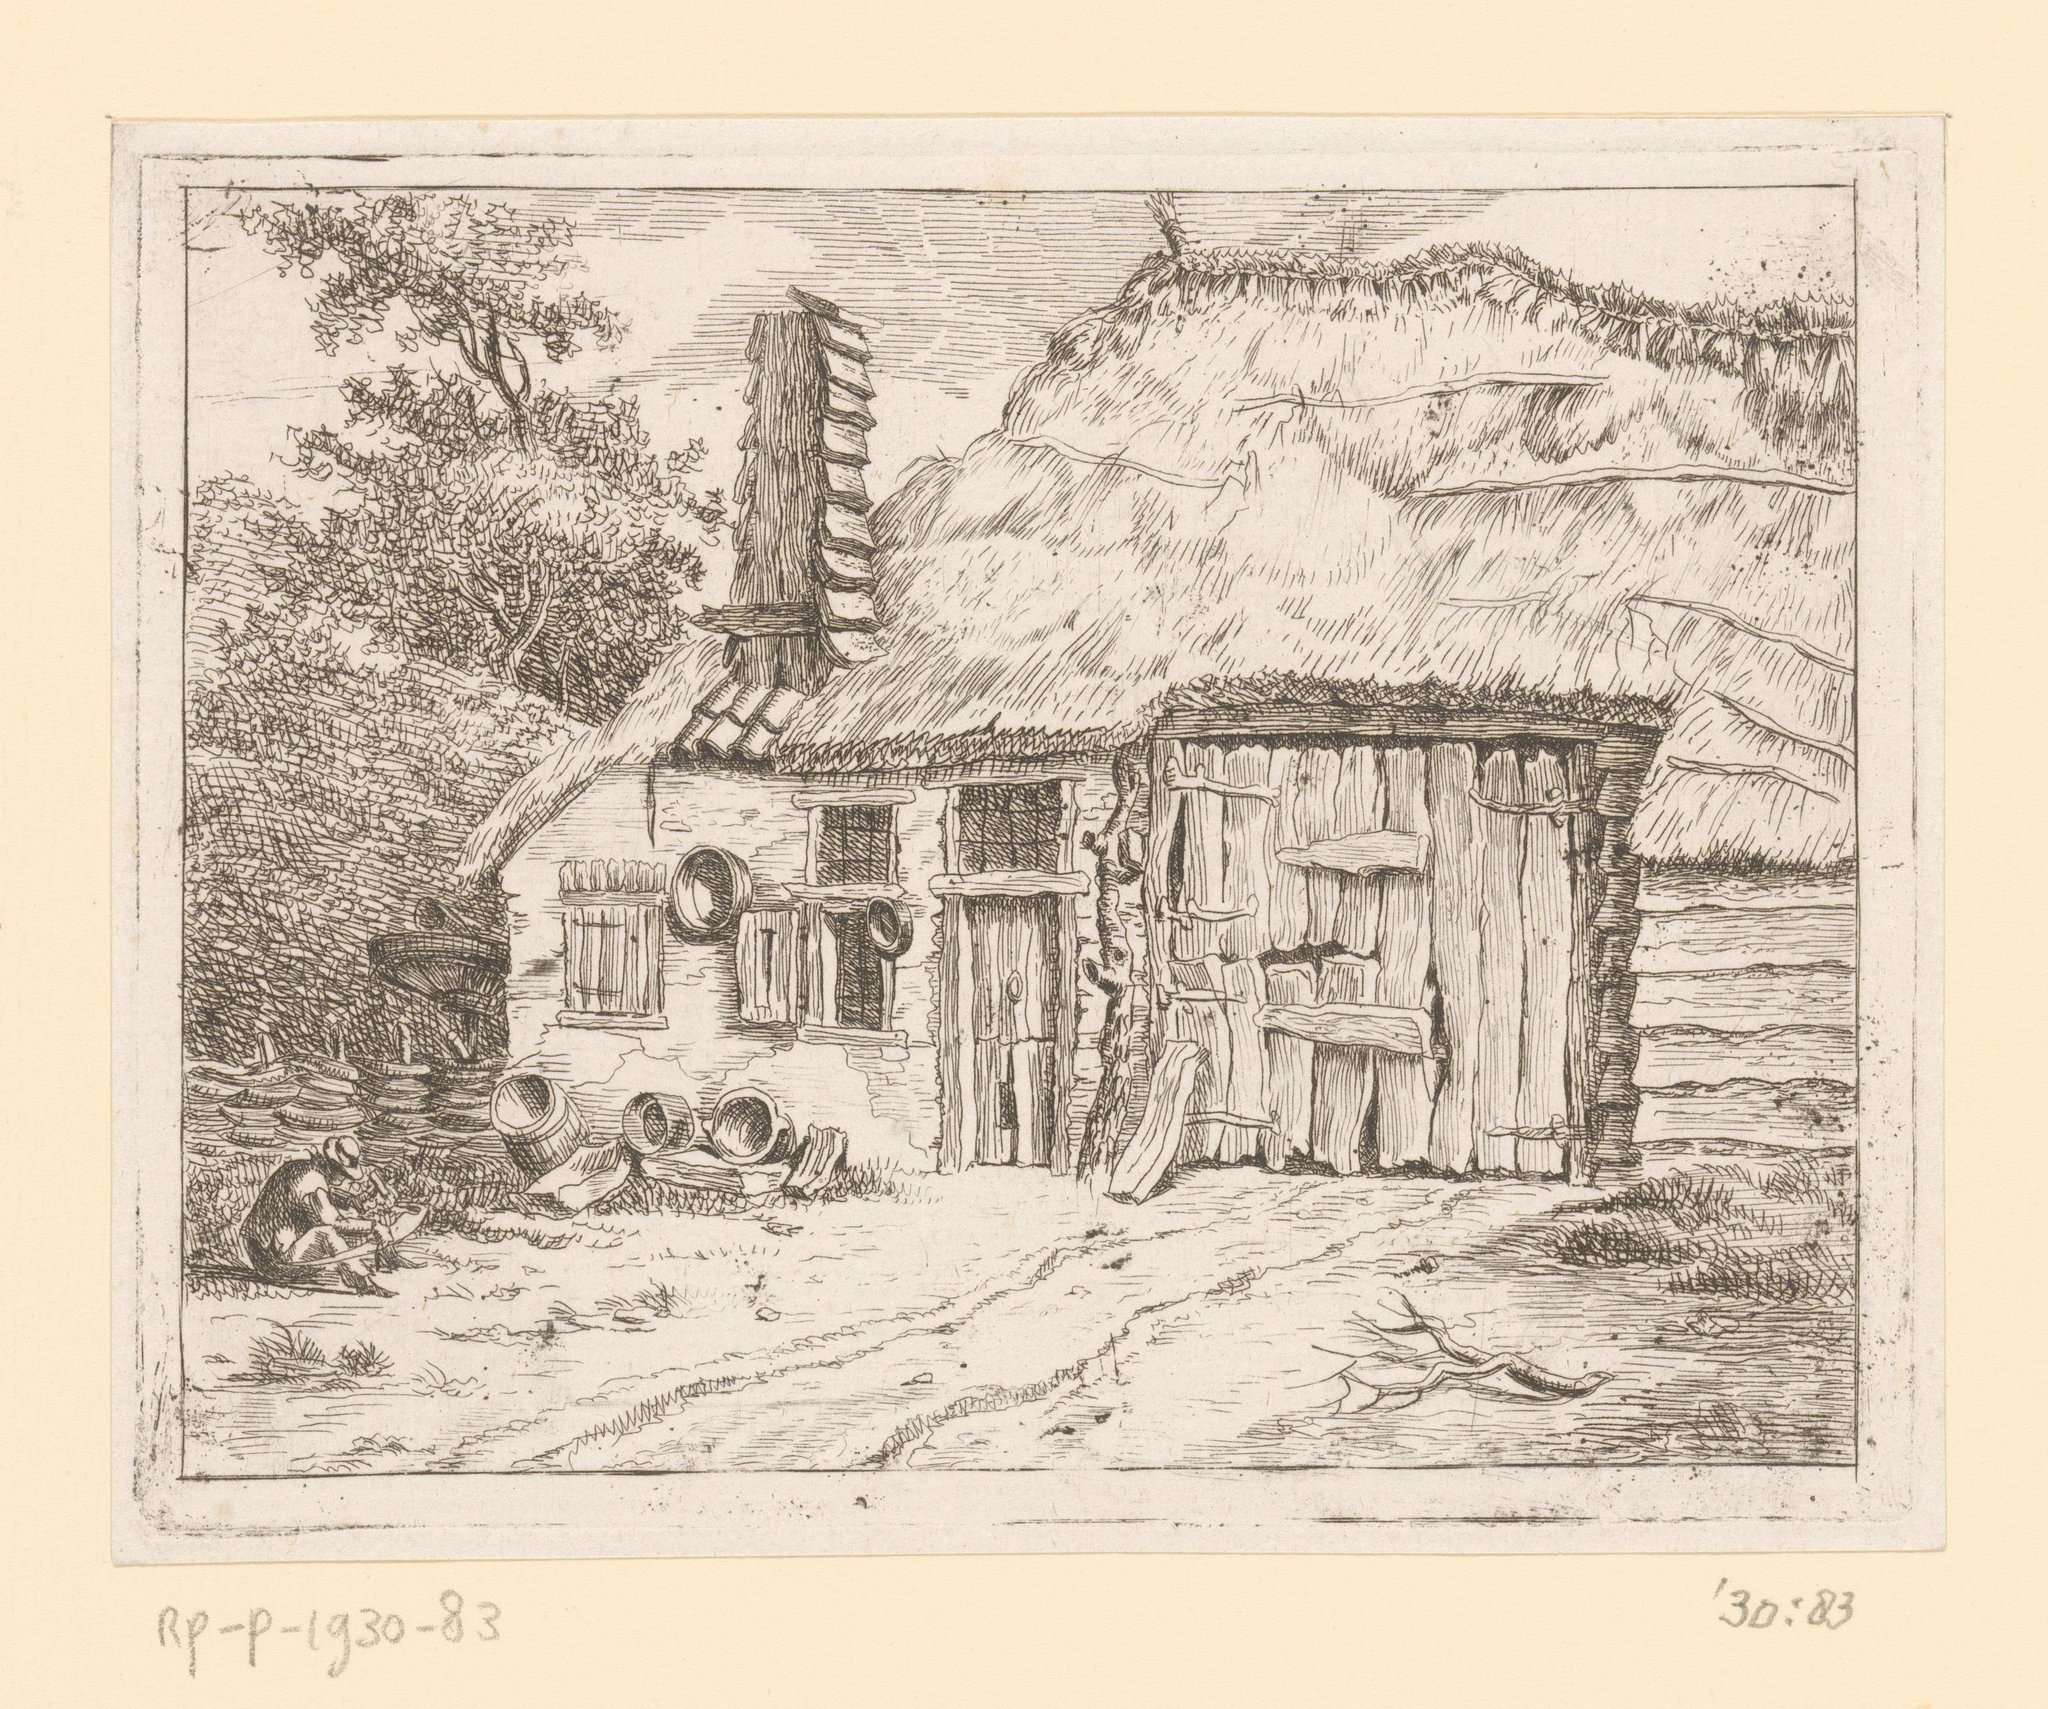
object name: print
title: Man met zeis zit voor een boerderij te Staphorst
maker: anthonie van den bos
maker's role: draughtsman, print maker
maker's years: 1763-1838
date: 1773-1838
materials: paper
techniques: etching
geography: netherlands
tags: agricultural implements: scythe, farm (building)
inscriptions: collector's mark: Lugt 2233, inscription: ‘Shorst in het Landt Drenthe’